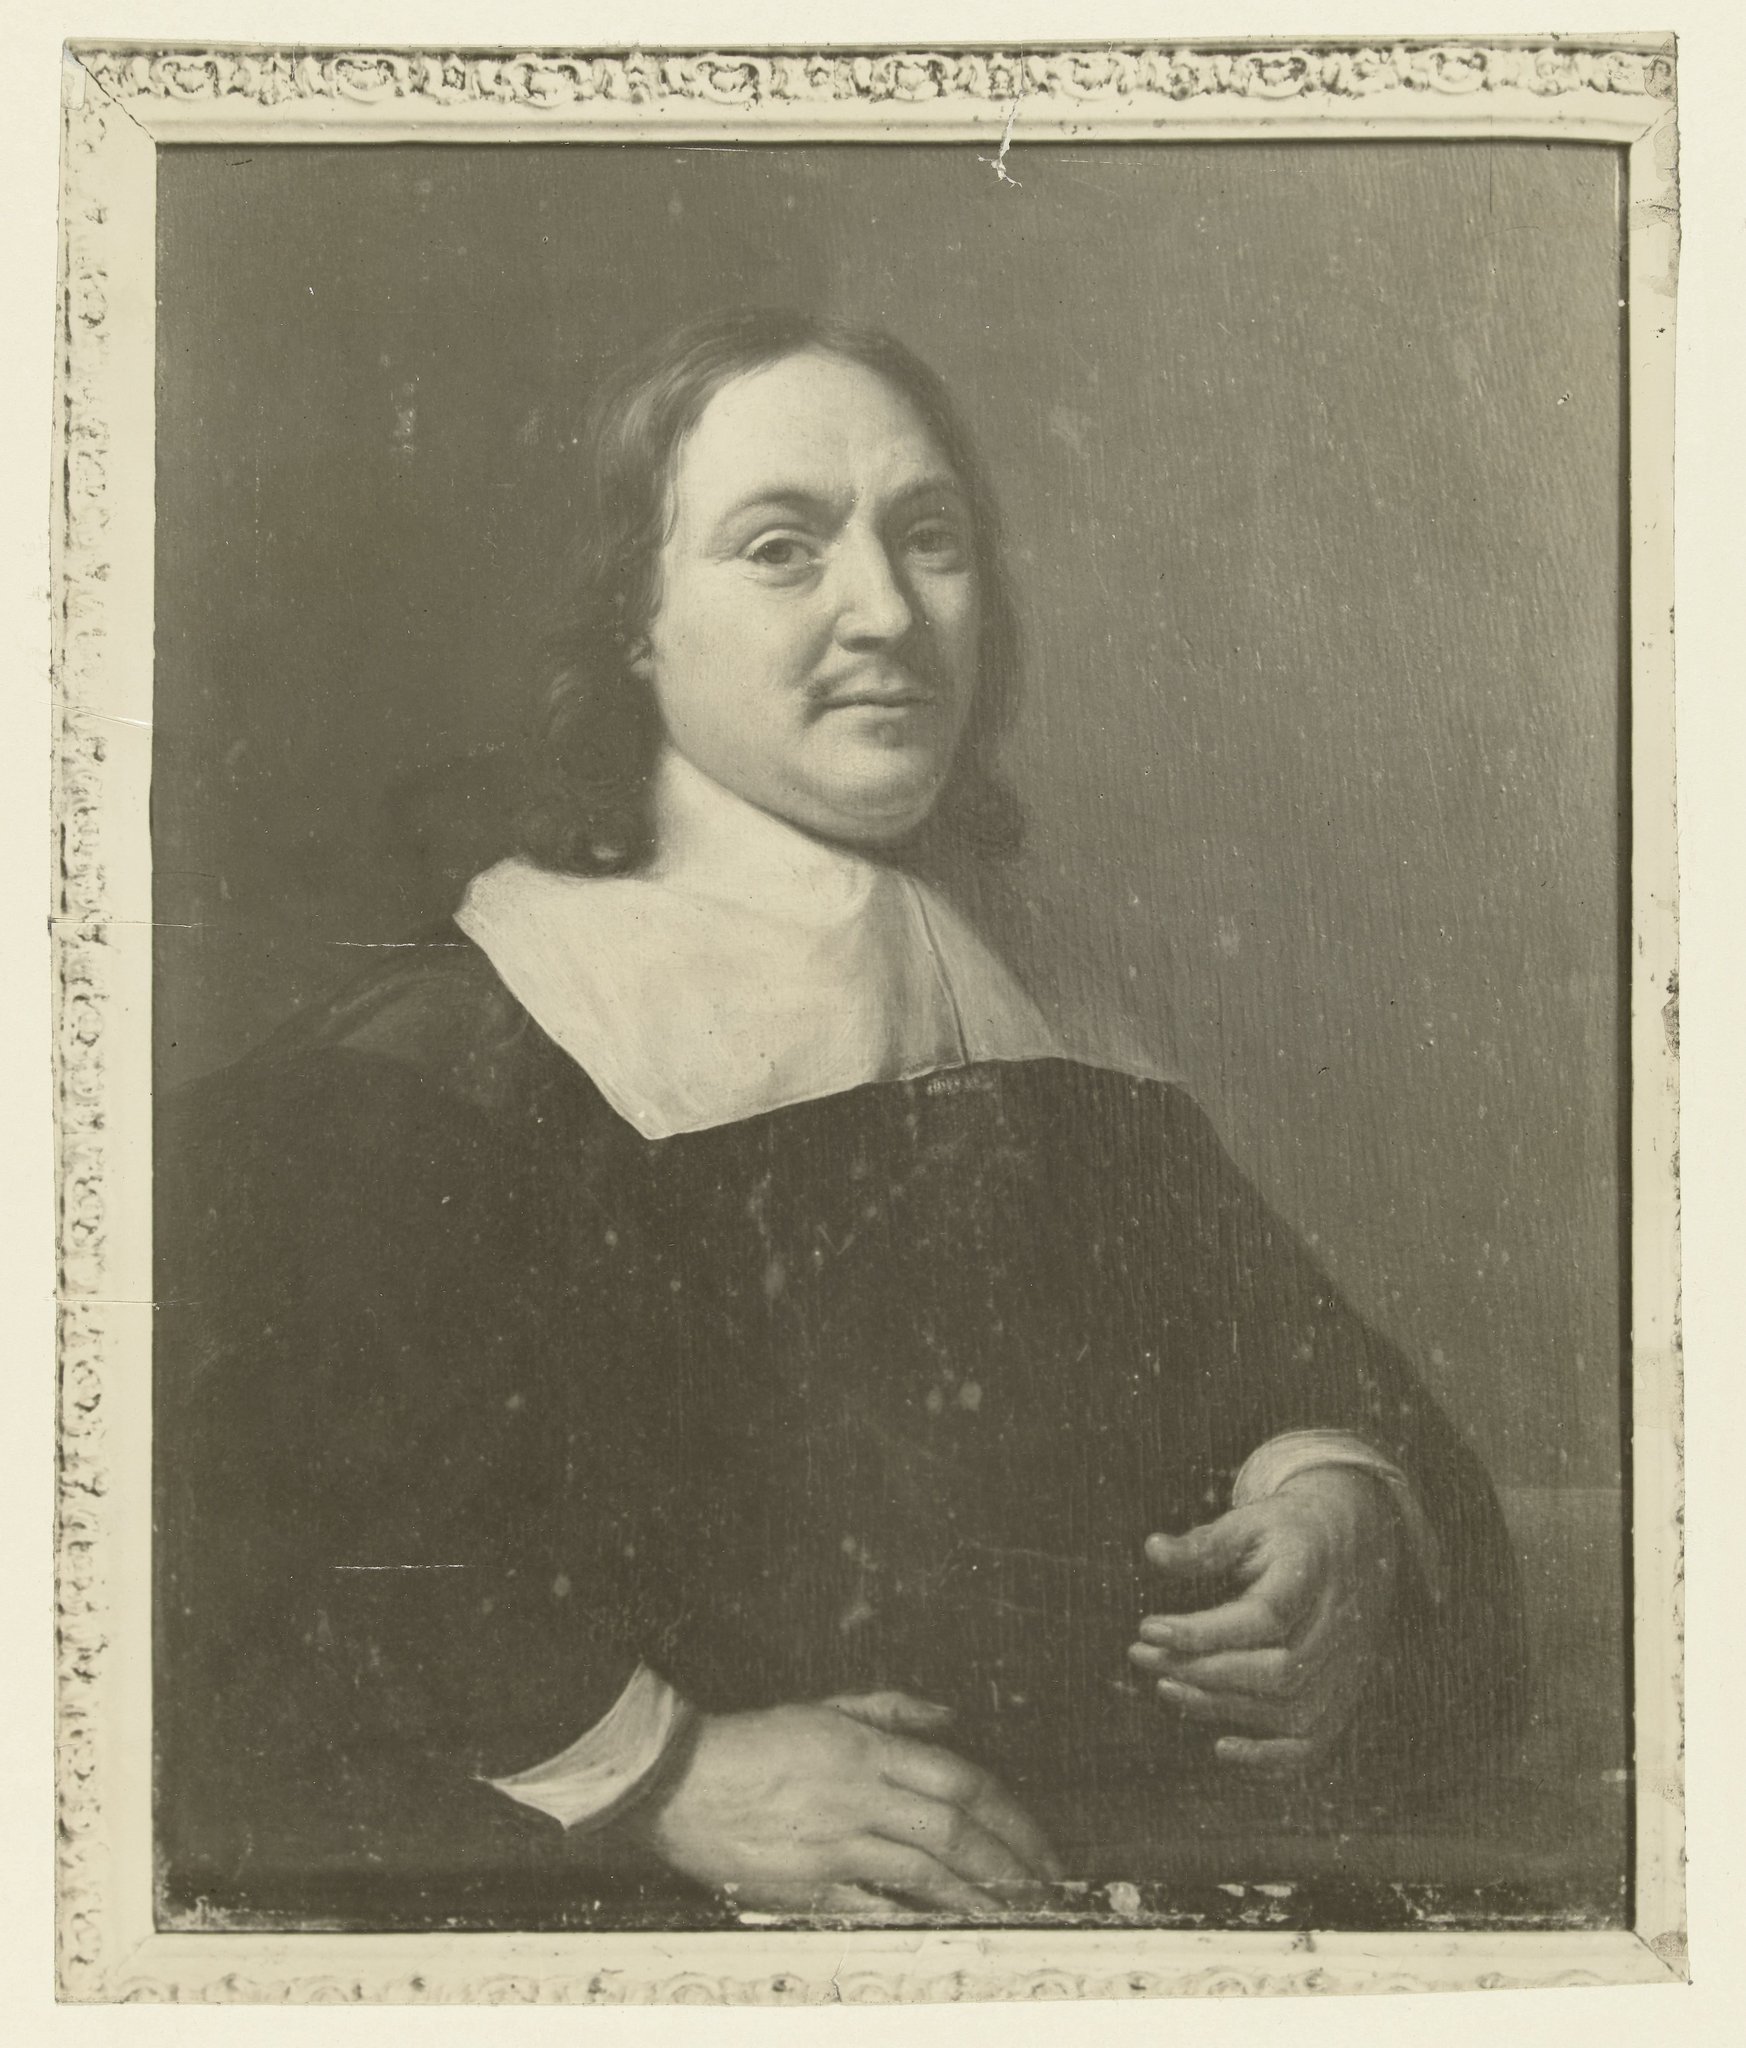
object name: photograph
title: Portret van een man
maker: Anonymous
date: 1890-1910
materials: cardboard, photographic support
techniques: gelatin silver print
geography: netherlands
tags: picture, painting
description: Foto-reproductie van een schilderij van een portret van een onbekende man